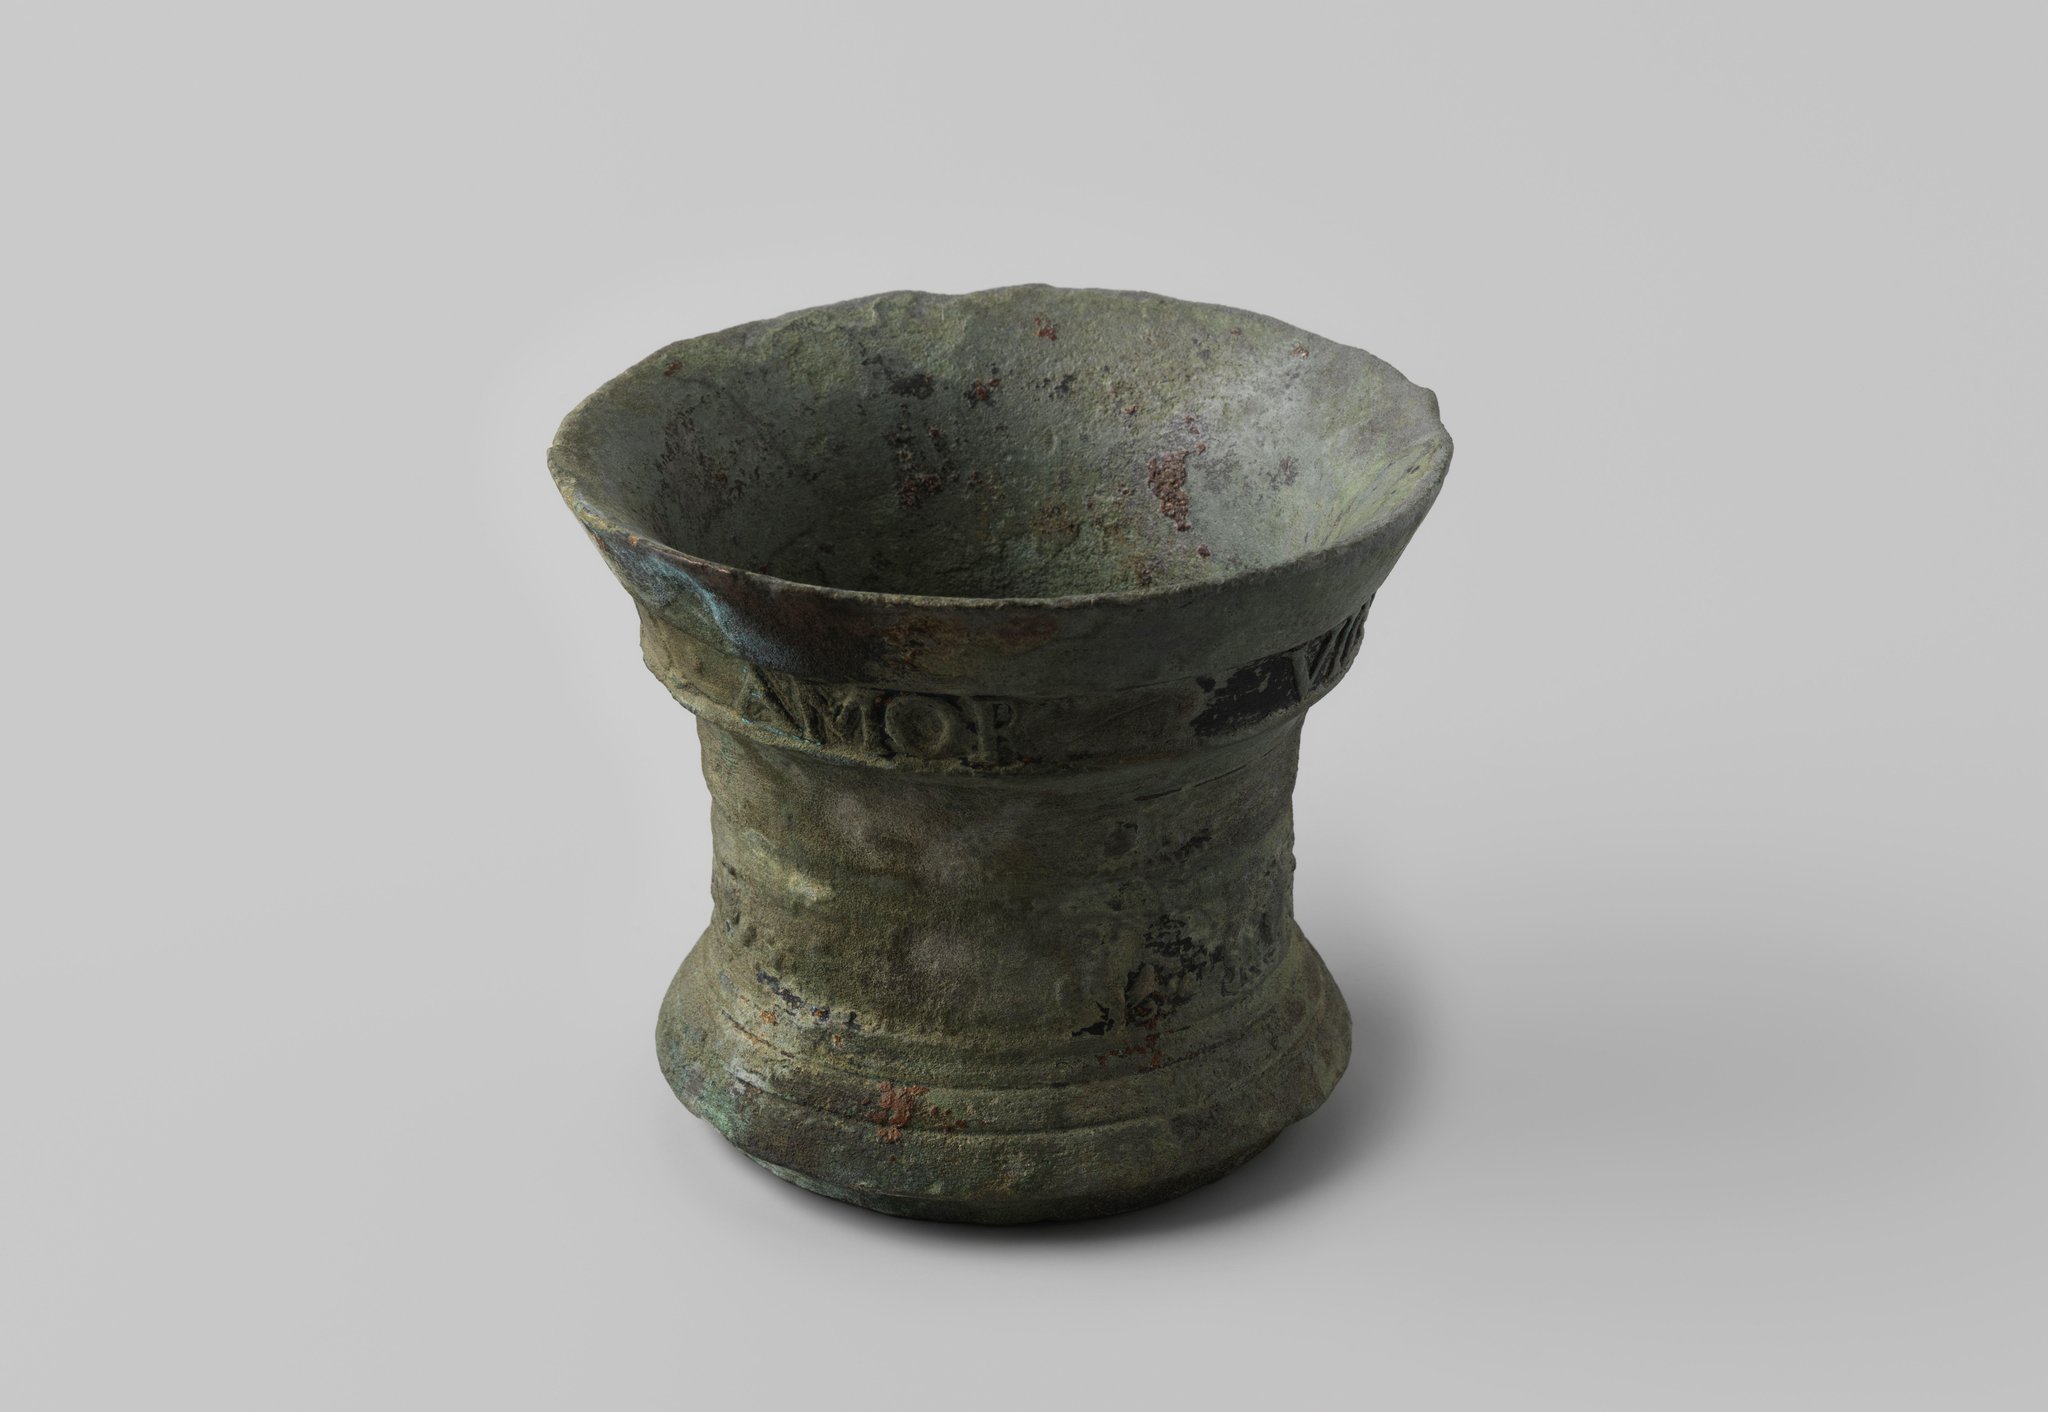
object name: mortar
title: Bronze mortar with inscription amor vincit omnia 1693 from the wreck of the Dutch East Indiaman Hollandia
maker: Anonymous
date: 1700-1743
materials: copper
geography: netherlands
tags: verenigde oostindische compagnie, hollandia (schip), annet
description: Tools and instruments, grinding and scharpening, mortar; bell-shaped, flat circular base, everted rim, relieved exterior decoration of three friezes, eroded, two with foliate motifs, one with text [AMOR VINCIT OMNIA 1693].